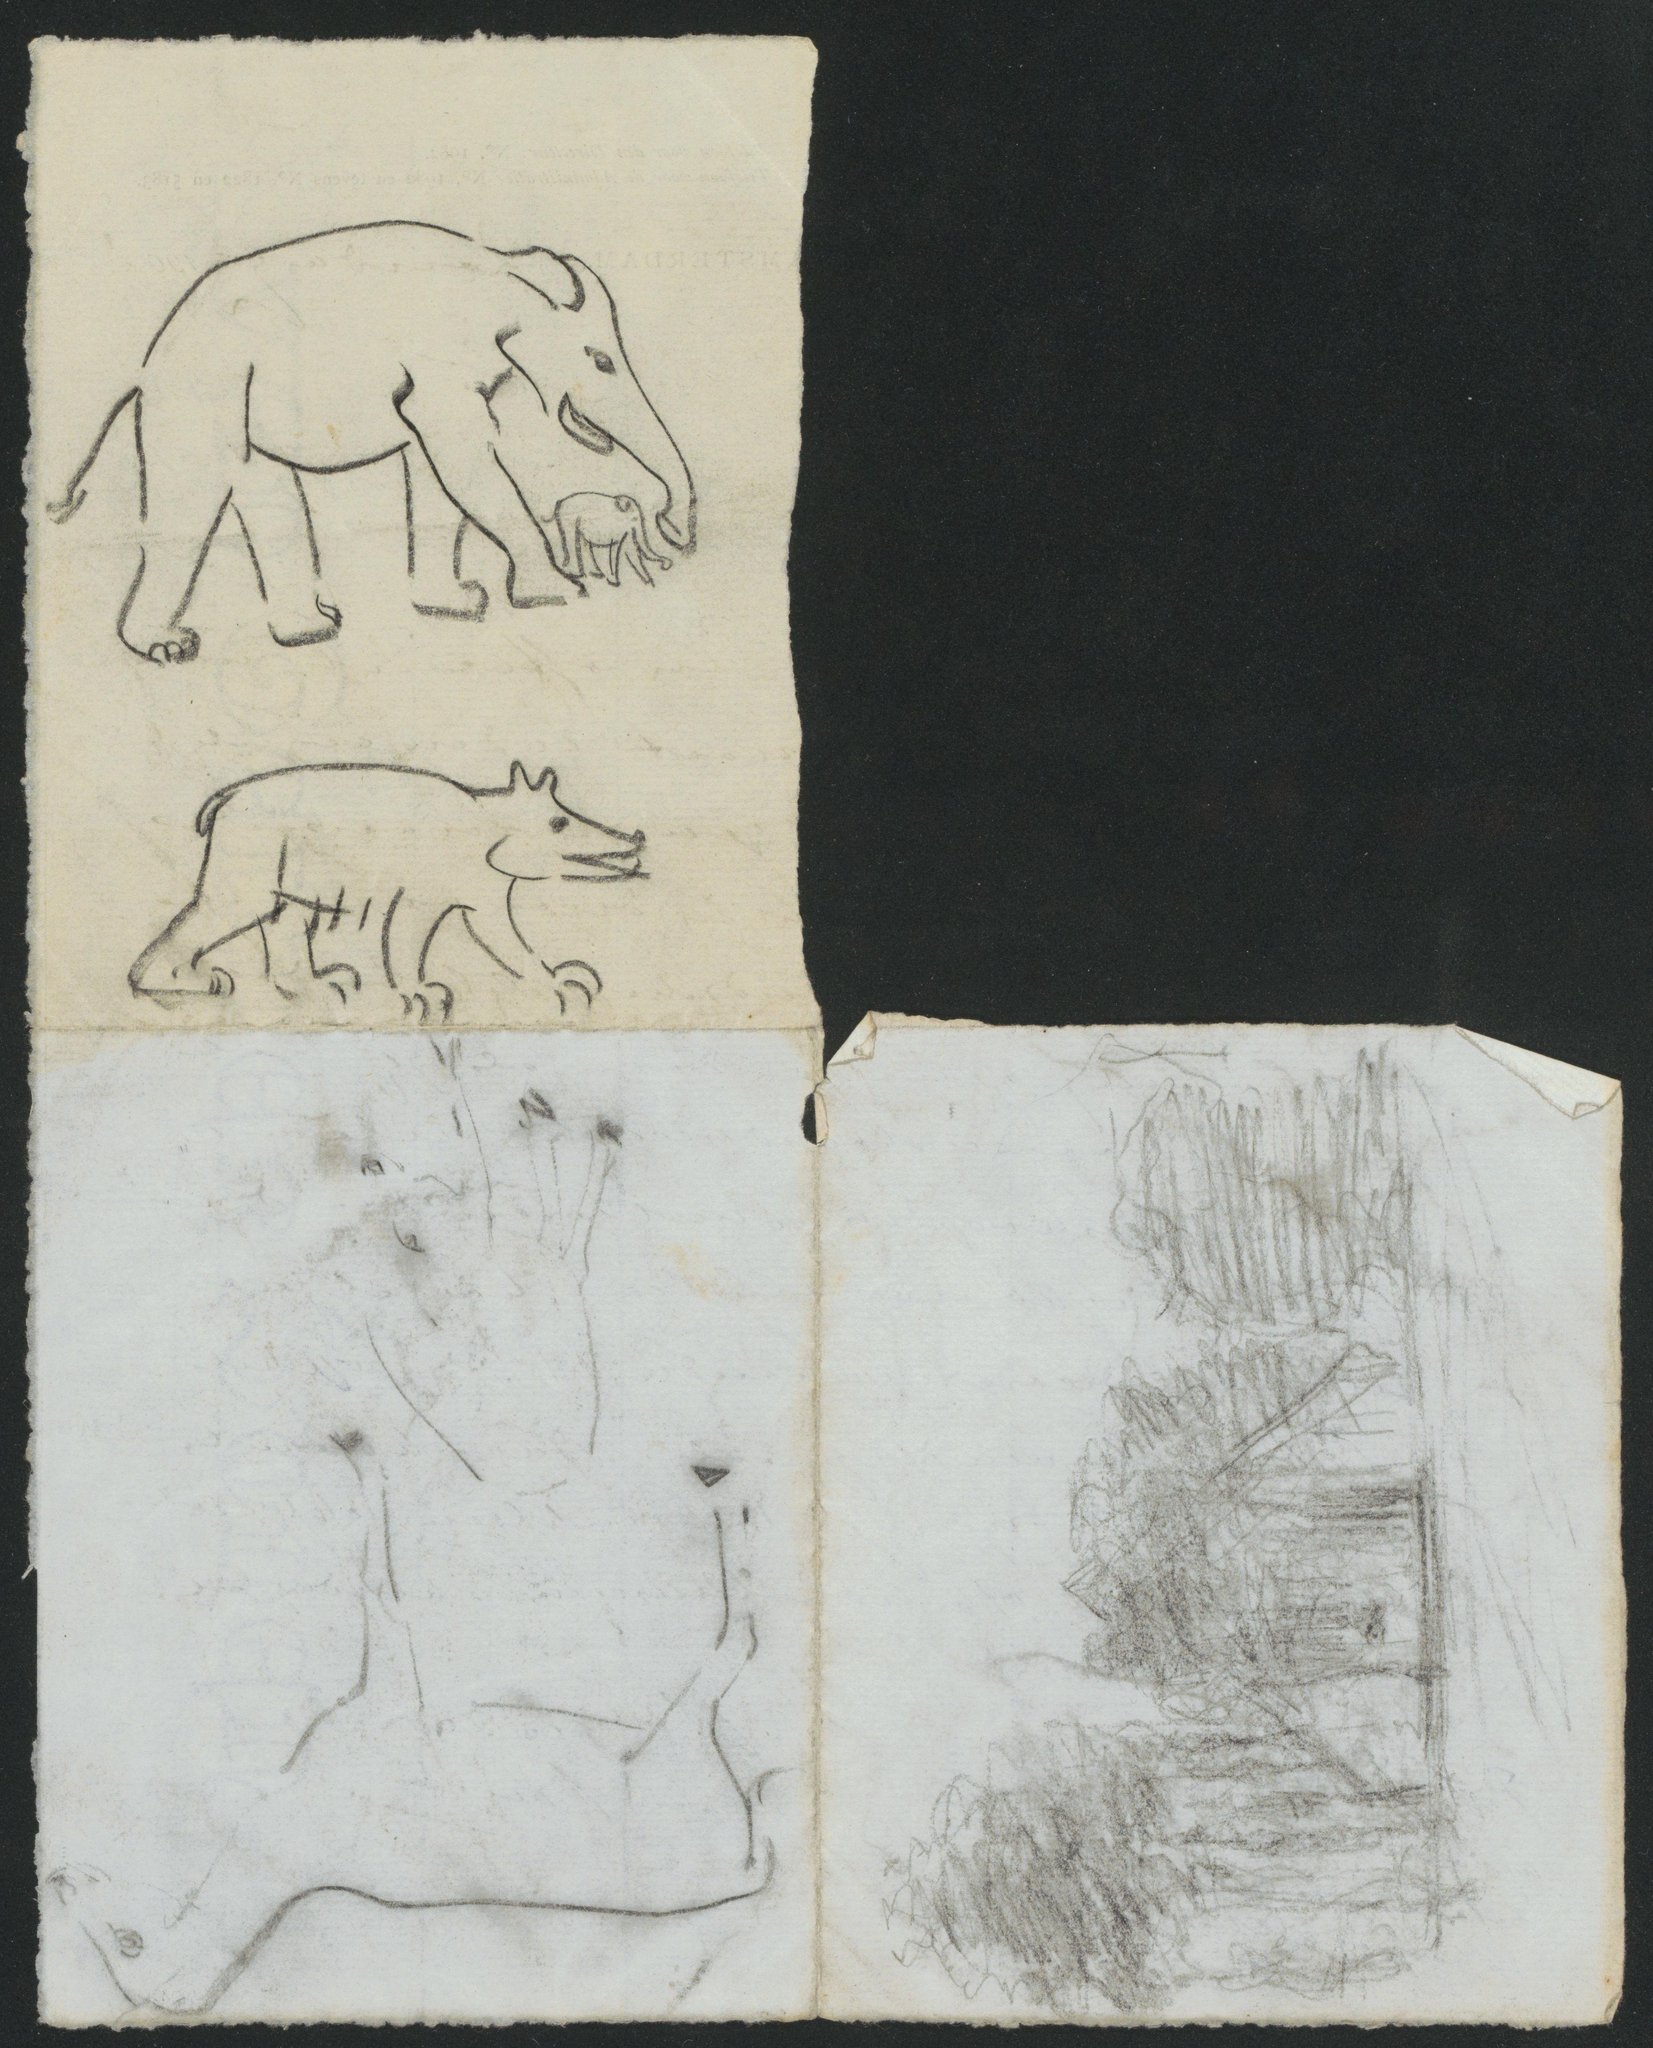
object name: drawing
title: Studieblad met olifanten en een huis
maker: gerrit willem dijsselhof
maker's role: designer, draughtsman, print maker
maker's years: 1866-1924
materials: chalk, paper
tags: cottage, trunked animals: elephant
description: Studieblad met twee olifanten, een zoogdier, een mogelijke paardachtige en een huis tussen de bomen.